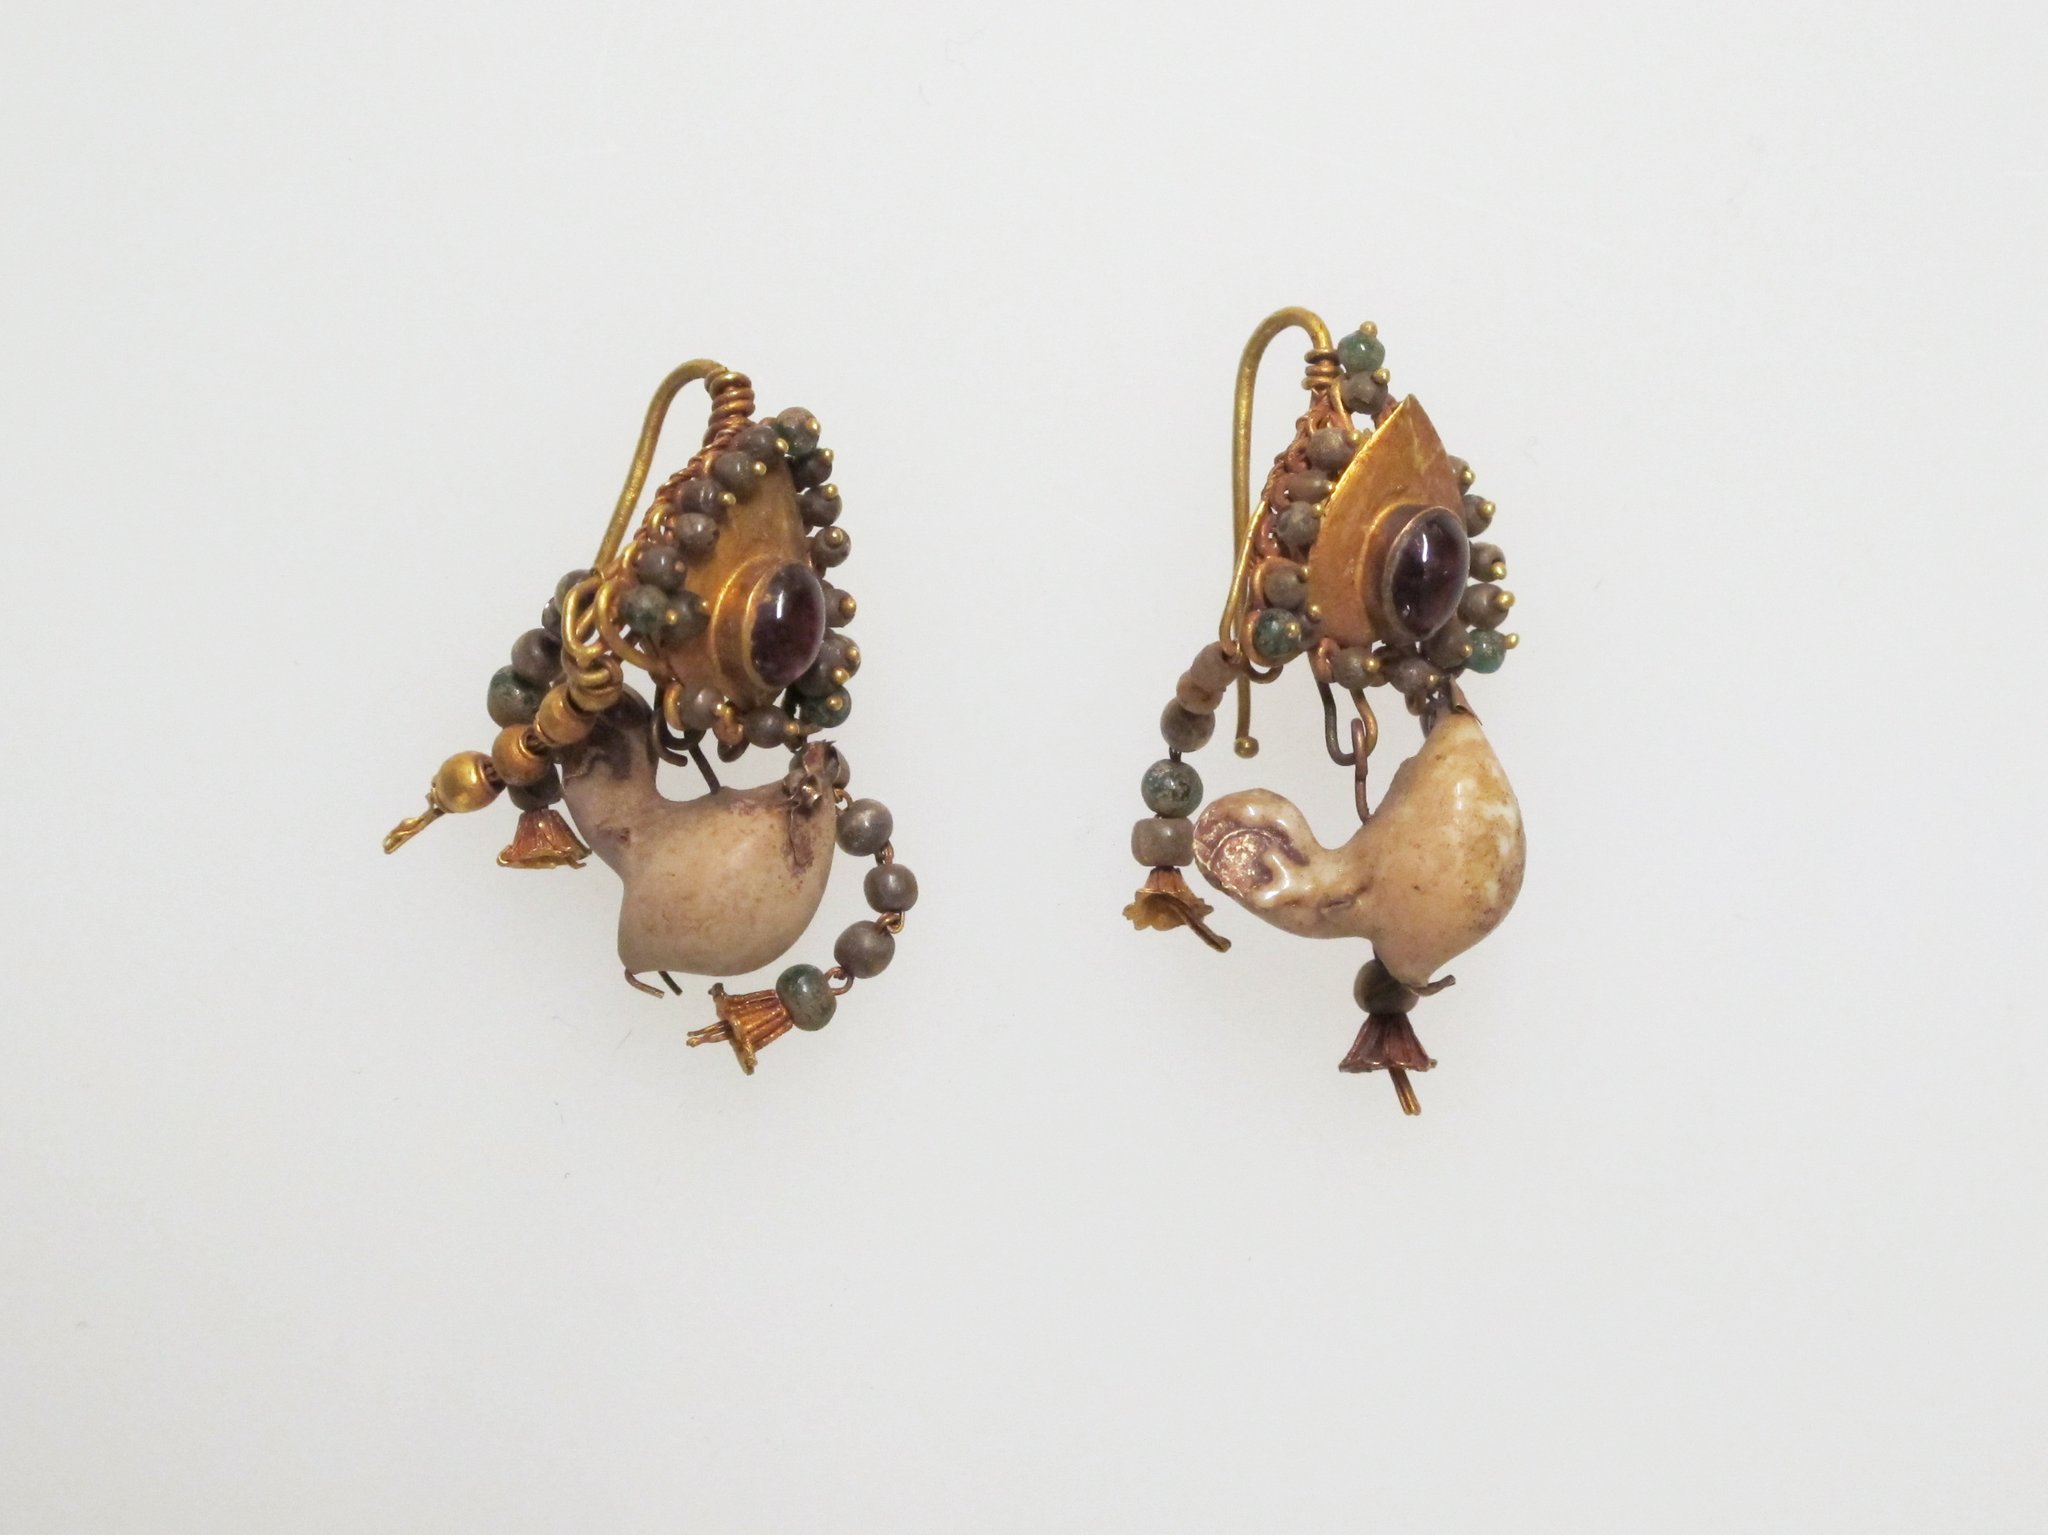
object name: earring with pendant of bird and glass bead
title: Earring with pendant of birds and glass beads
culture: greek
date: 323 BCE-31 CE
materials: glass, gold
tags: birds